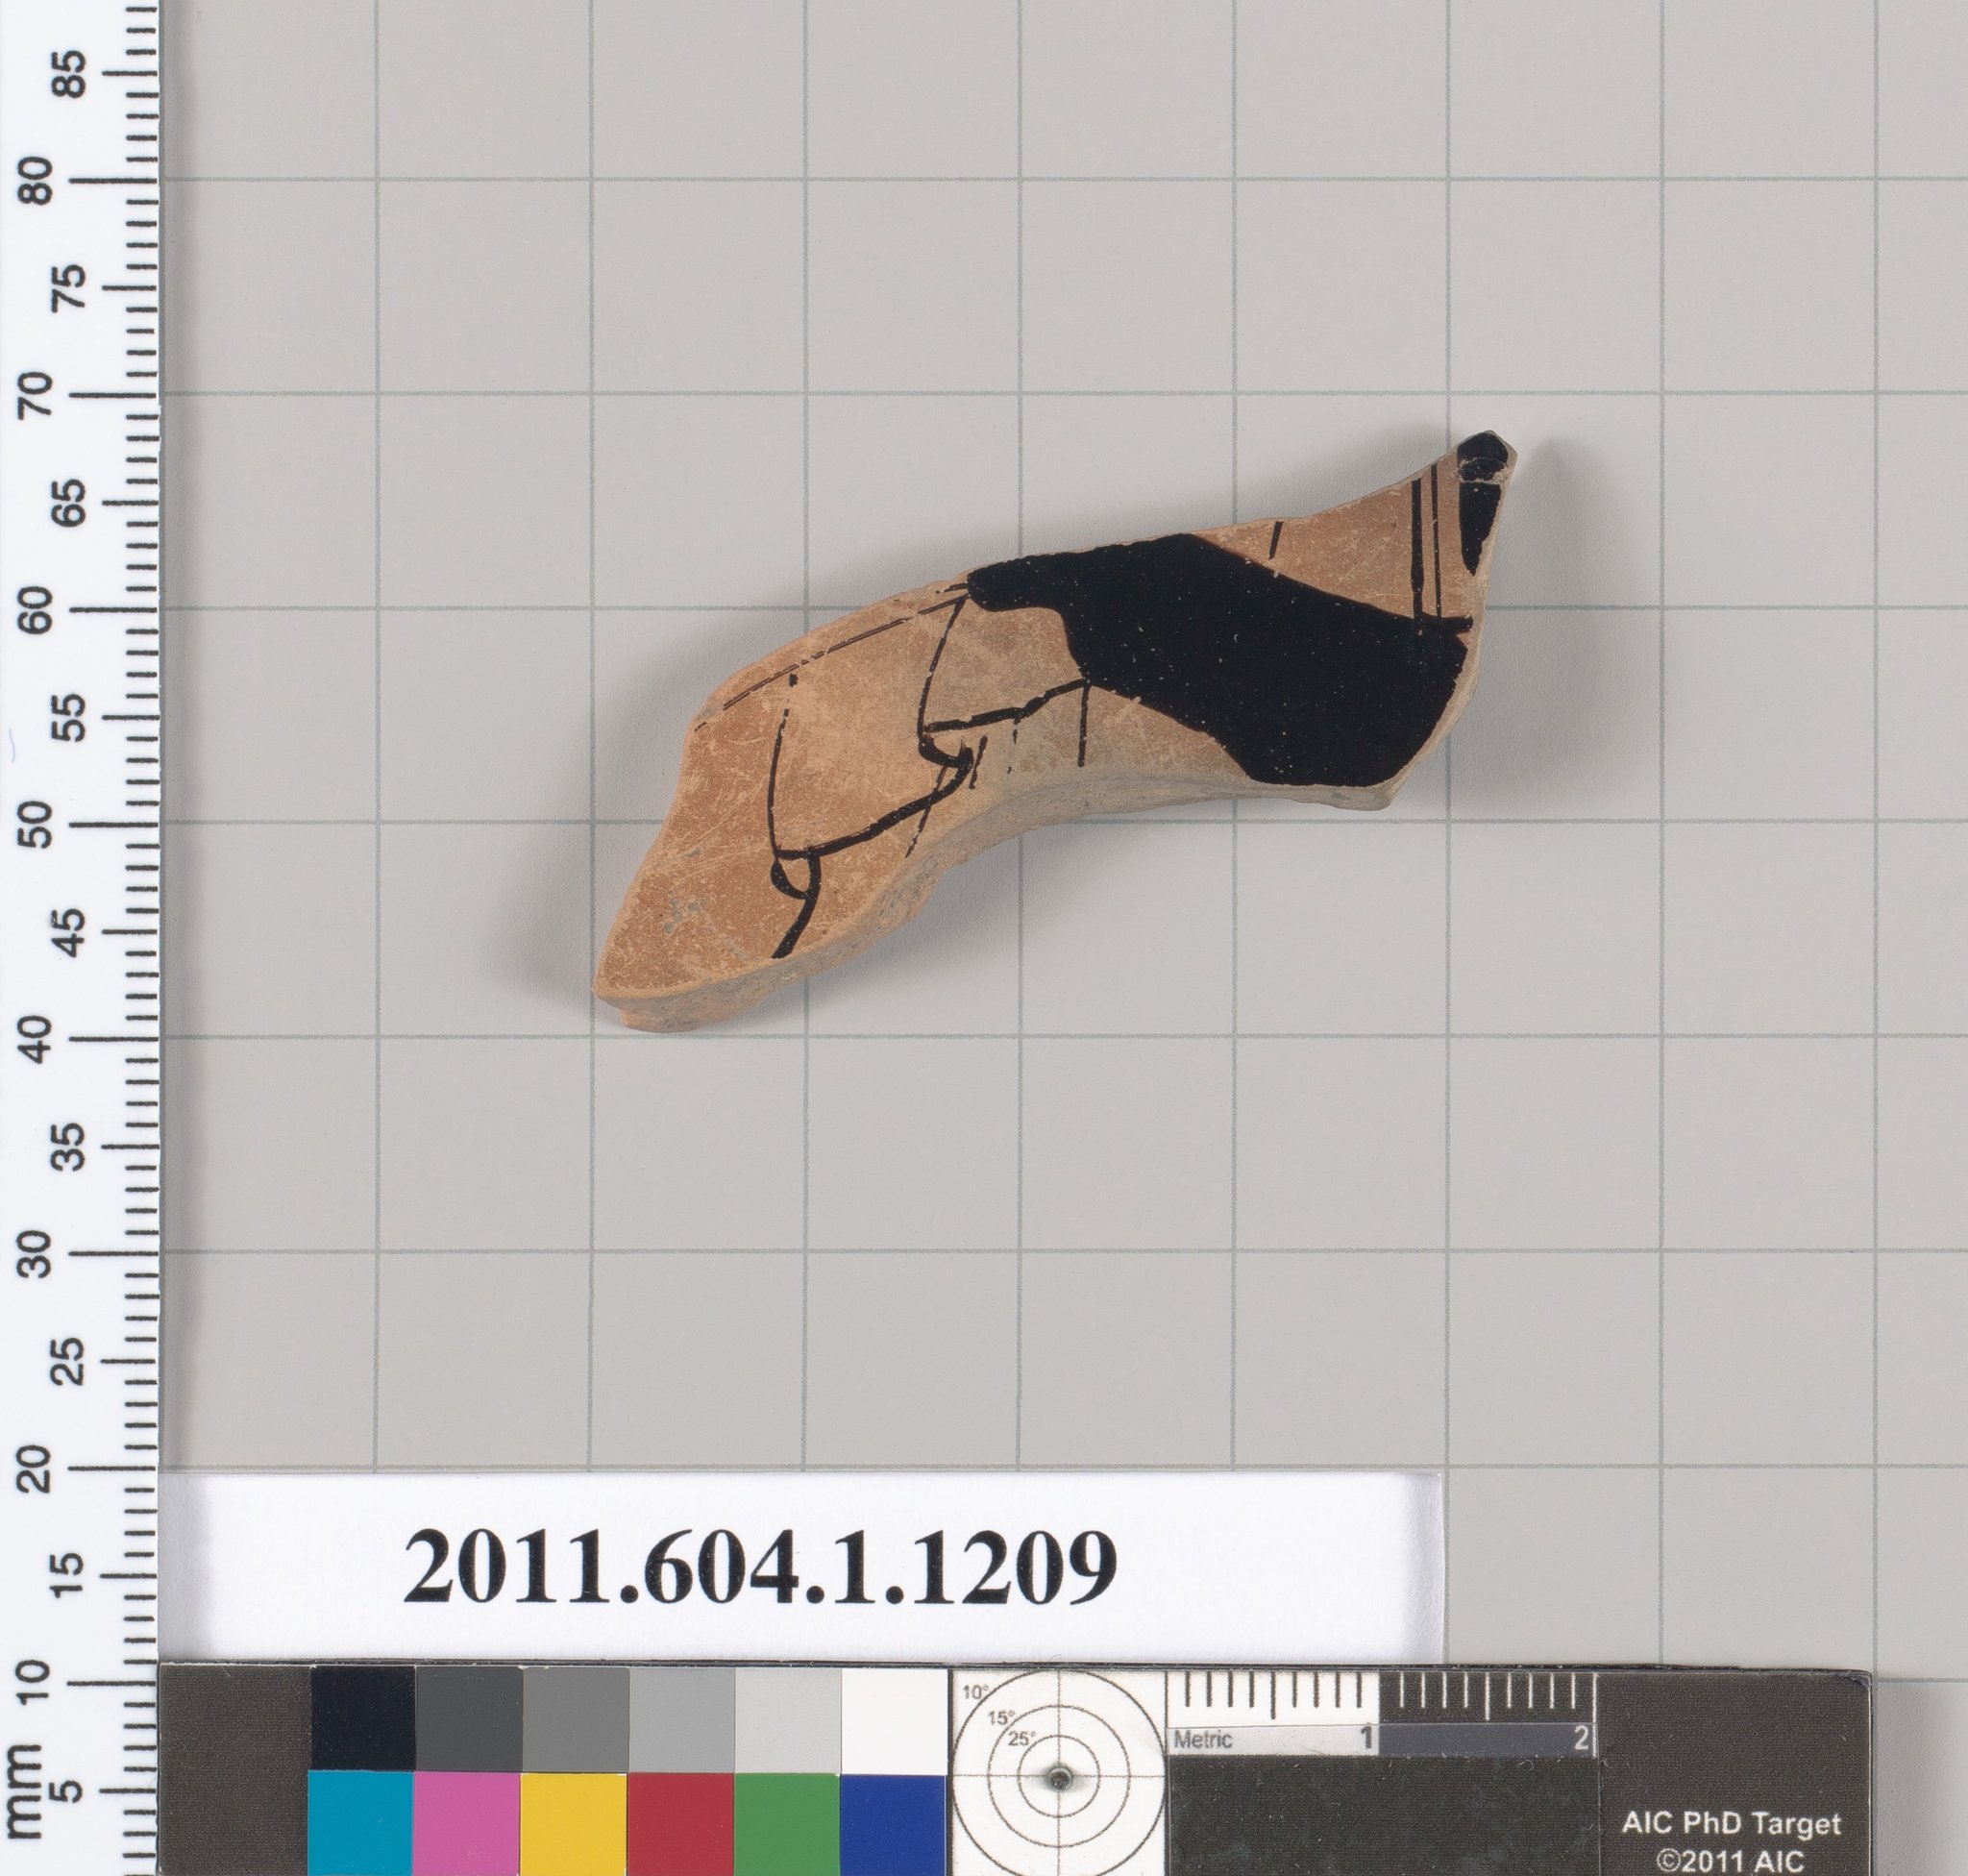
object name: kylix fragment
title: Terracotta fragment of a kylix (drinking cup)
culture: greek, attic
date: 475-451 BCE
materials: terracotta